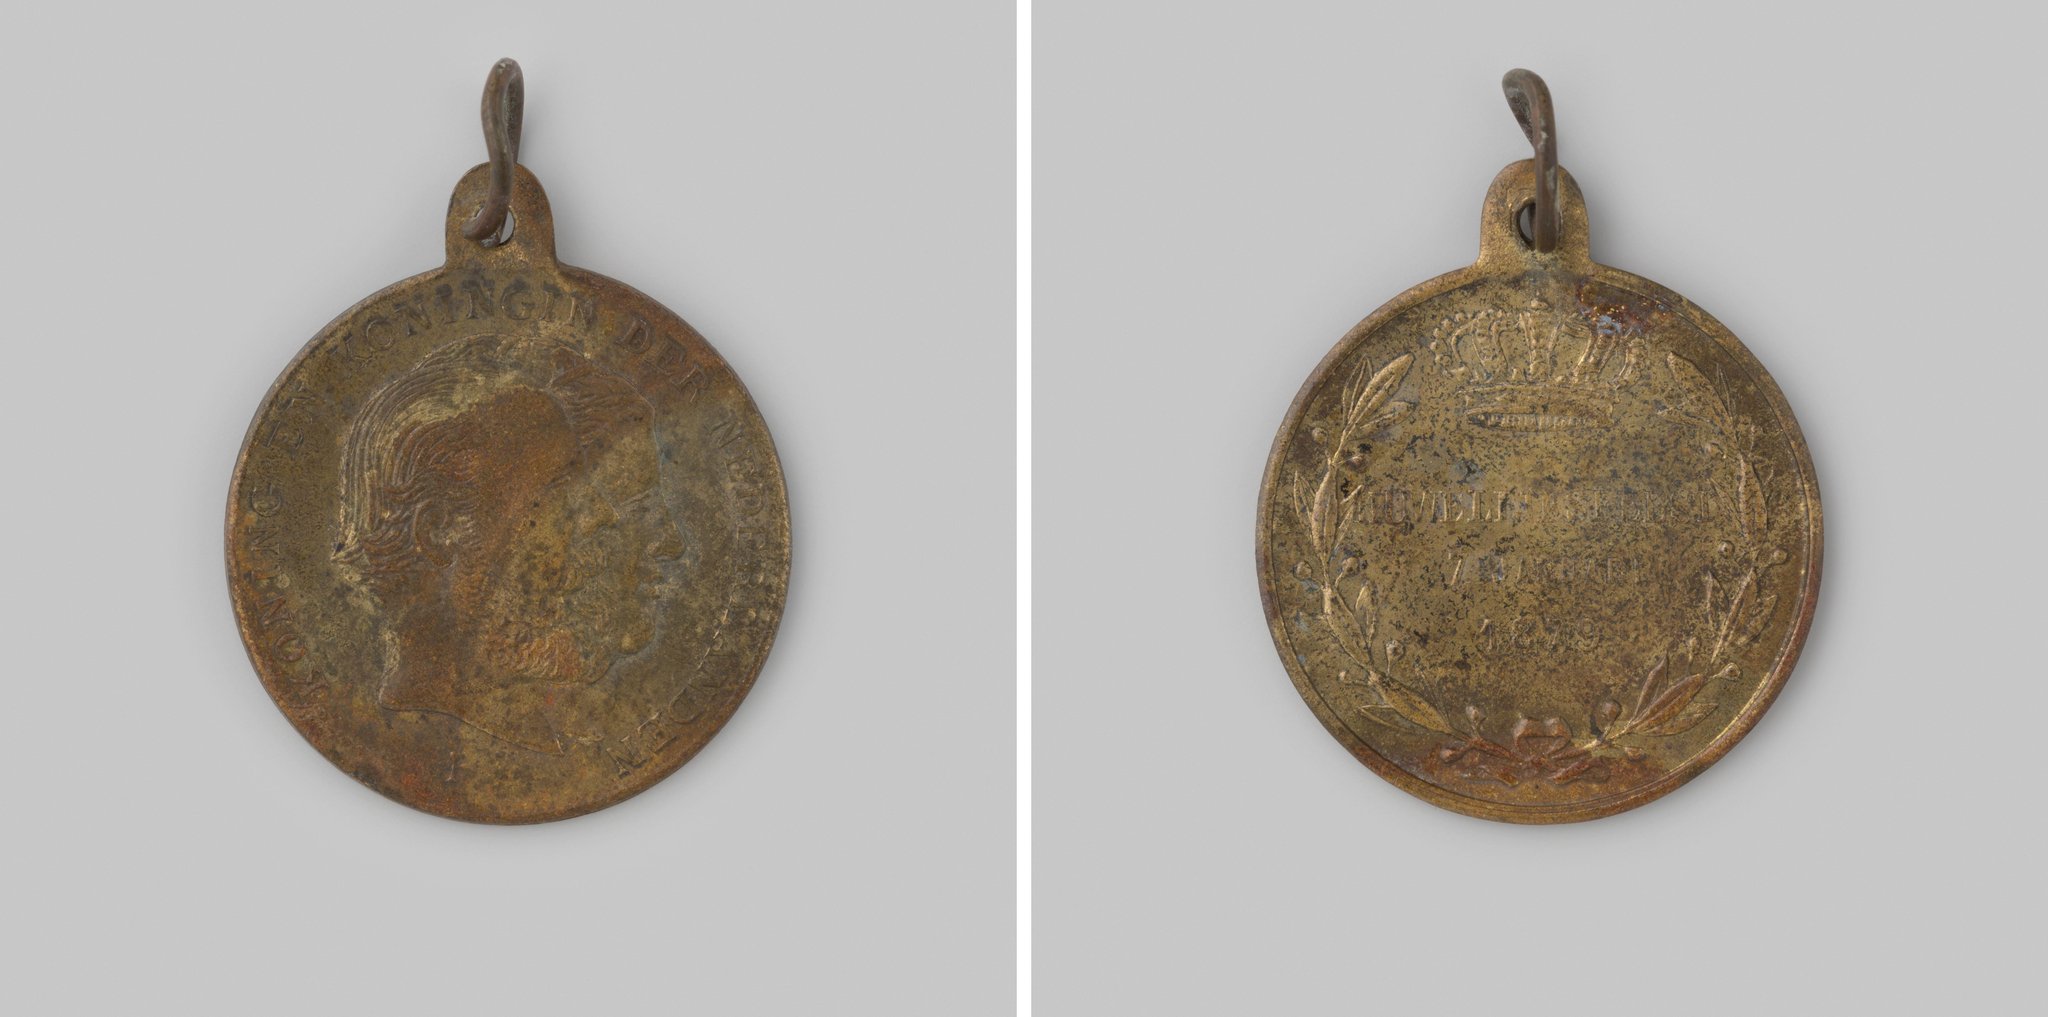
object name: history medal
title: Huwelijk van Willem III, koning der Nederlanden en Emma, prinses van Waldeck-Pyrmont te Arolsen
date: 1879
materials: metal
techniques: gilding, striking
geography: amsterdam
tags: emma (queen consort of the netherlands), willem iii (koning der nederlanden)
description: penning aan draagoog en draagring. Voorzijde: borststuk man en vrouw binnen omschrift. Keerzijde: opschrift onder kroon binnen lauwerkrans